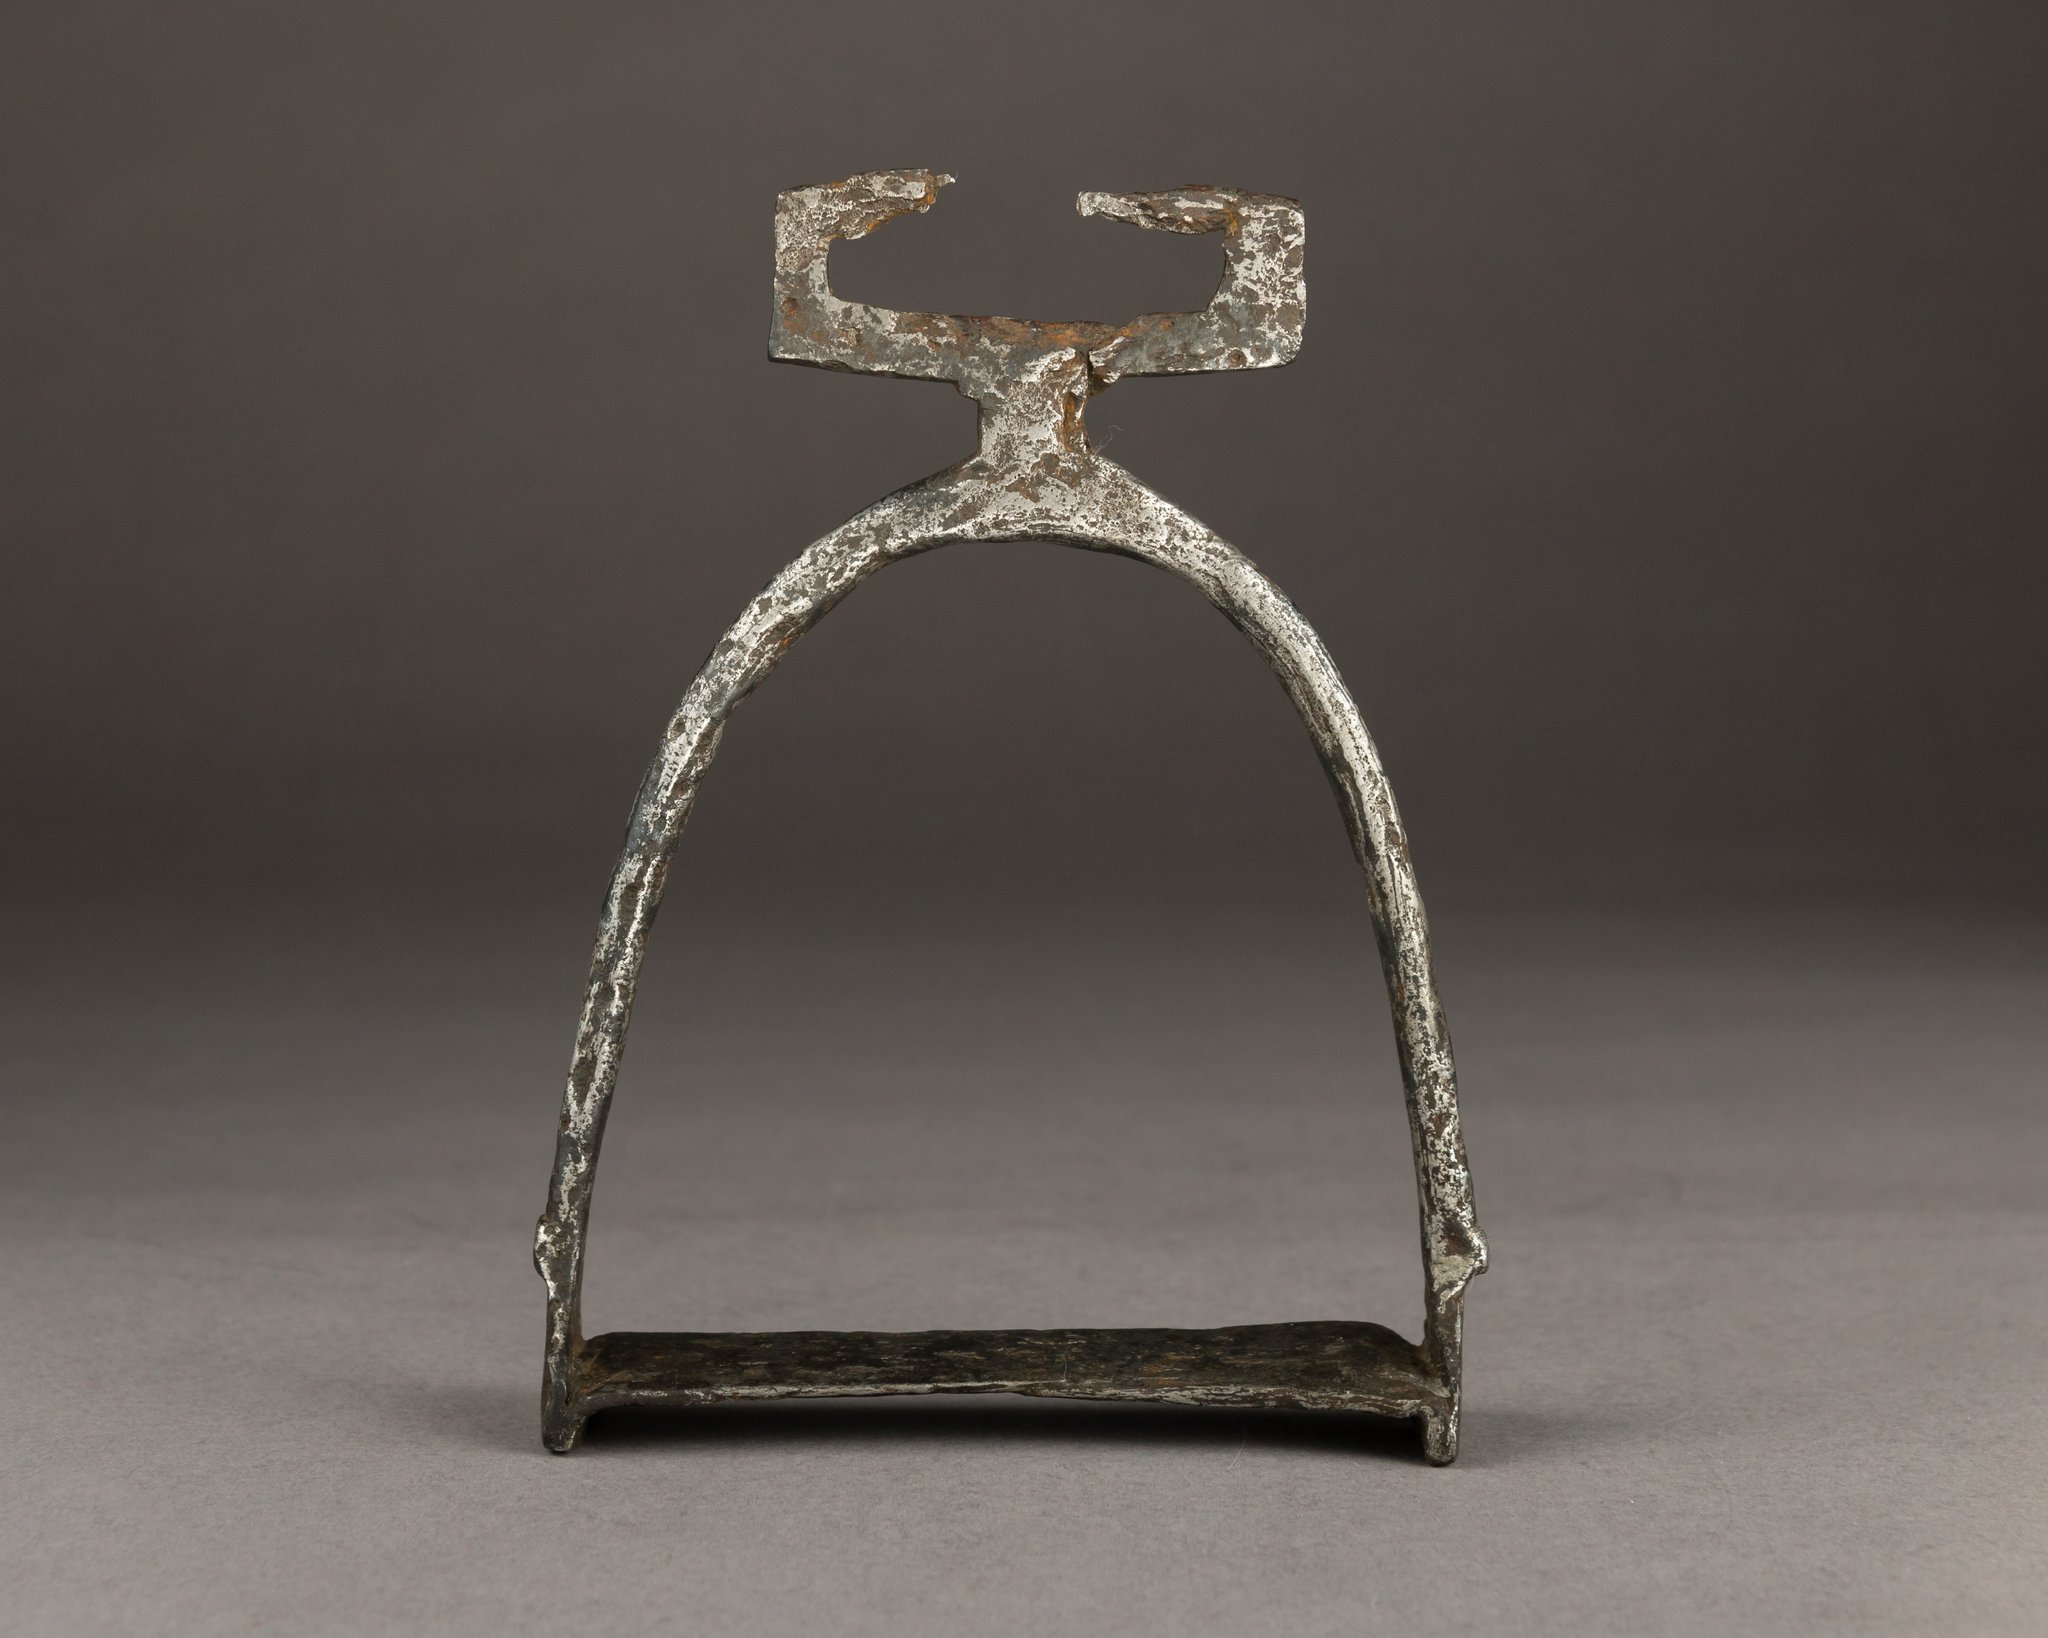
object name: stirrup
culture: german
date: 901-1100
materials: iron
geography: poland